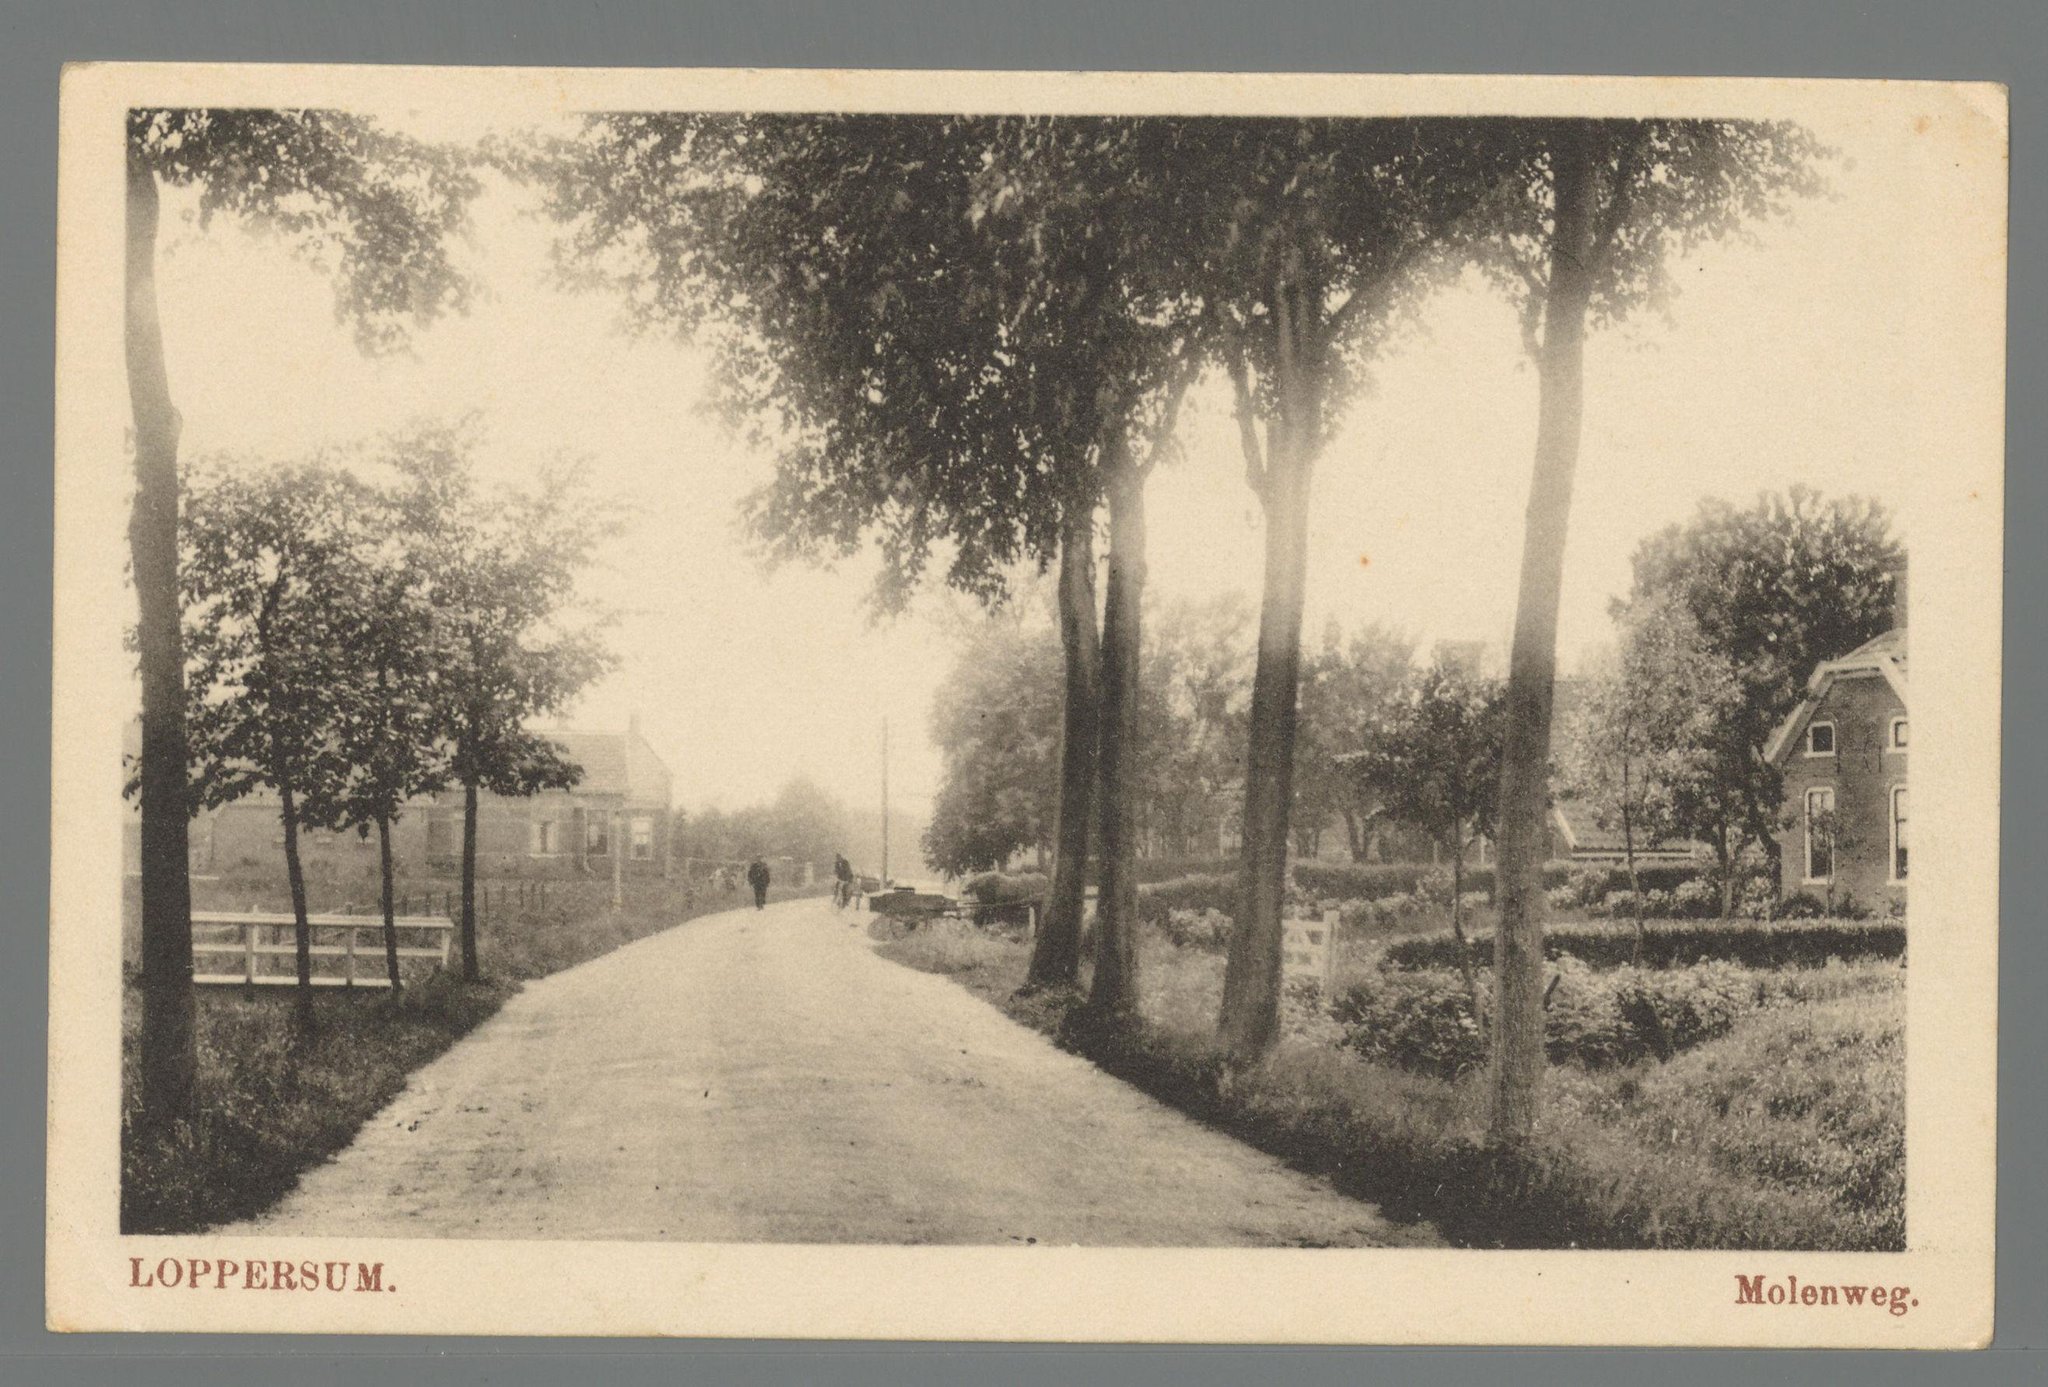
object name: photomechanical print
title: Loppersum. Molenweg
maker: Anonymous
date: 1913-1917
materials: cardboard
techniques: photograph, writing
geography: loppersum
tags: lane, alley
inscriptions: postage stamp